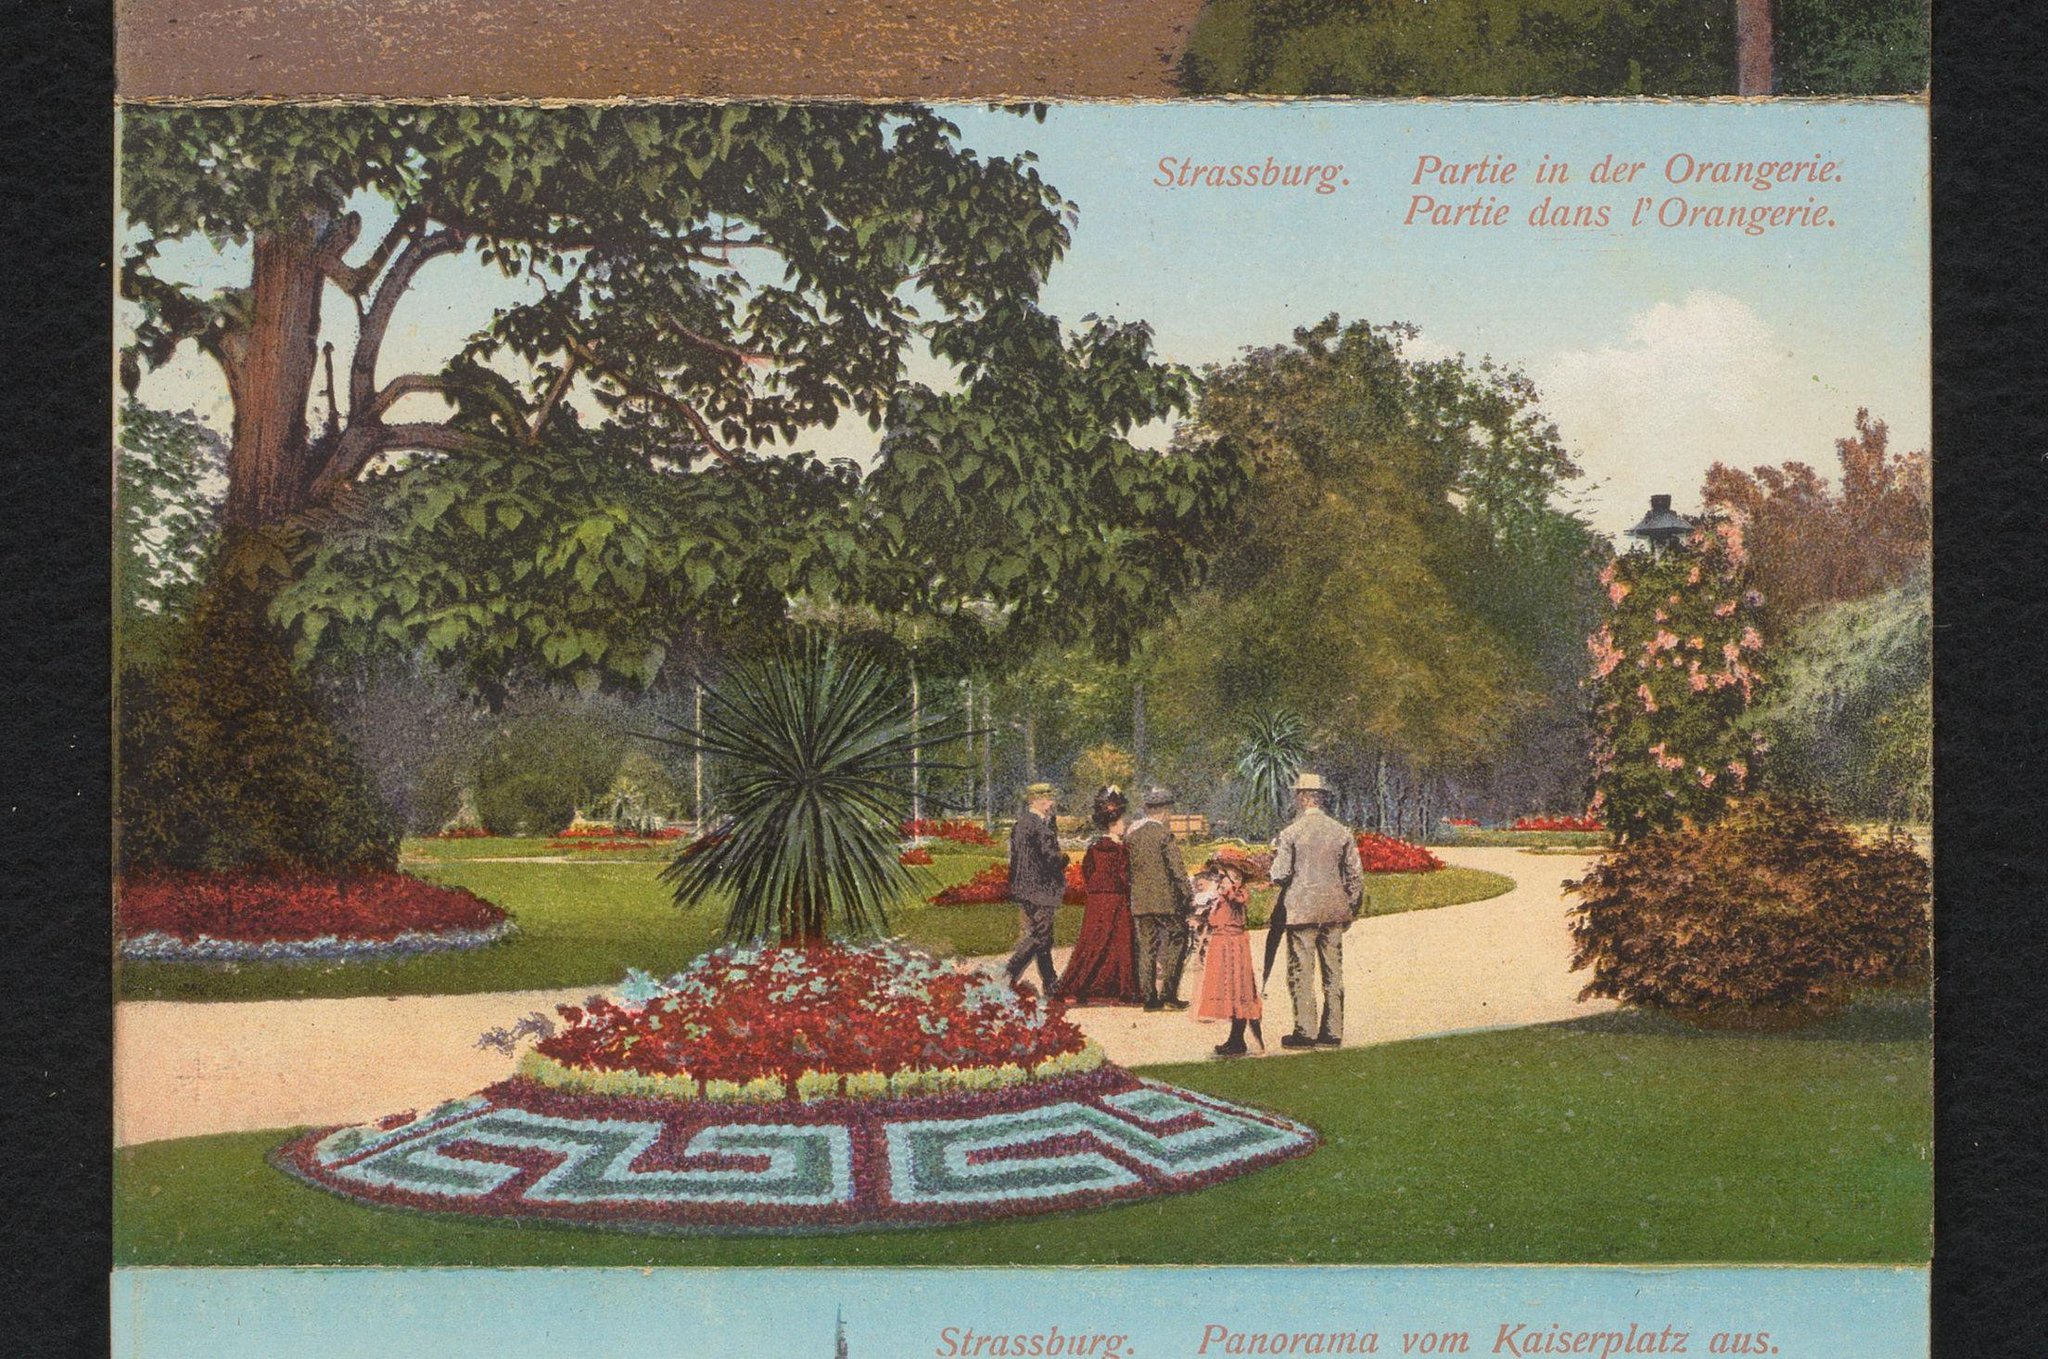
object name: ansichtkaart, prentbriefkaart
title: Strassburg. Partie in der Orangerie / Partie dans l'Orangerie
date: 1905-1930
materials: cardboard, photographic process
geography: straatsburg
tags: park